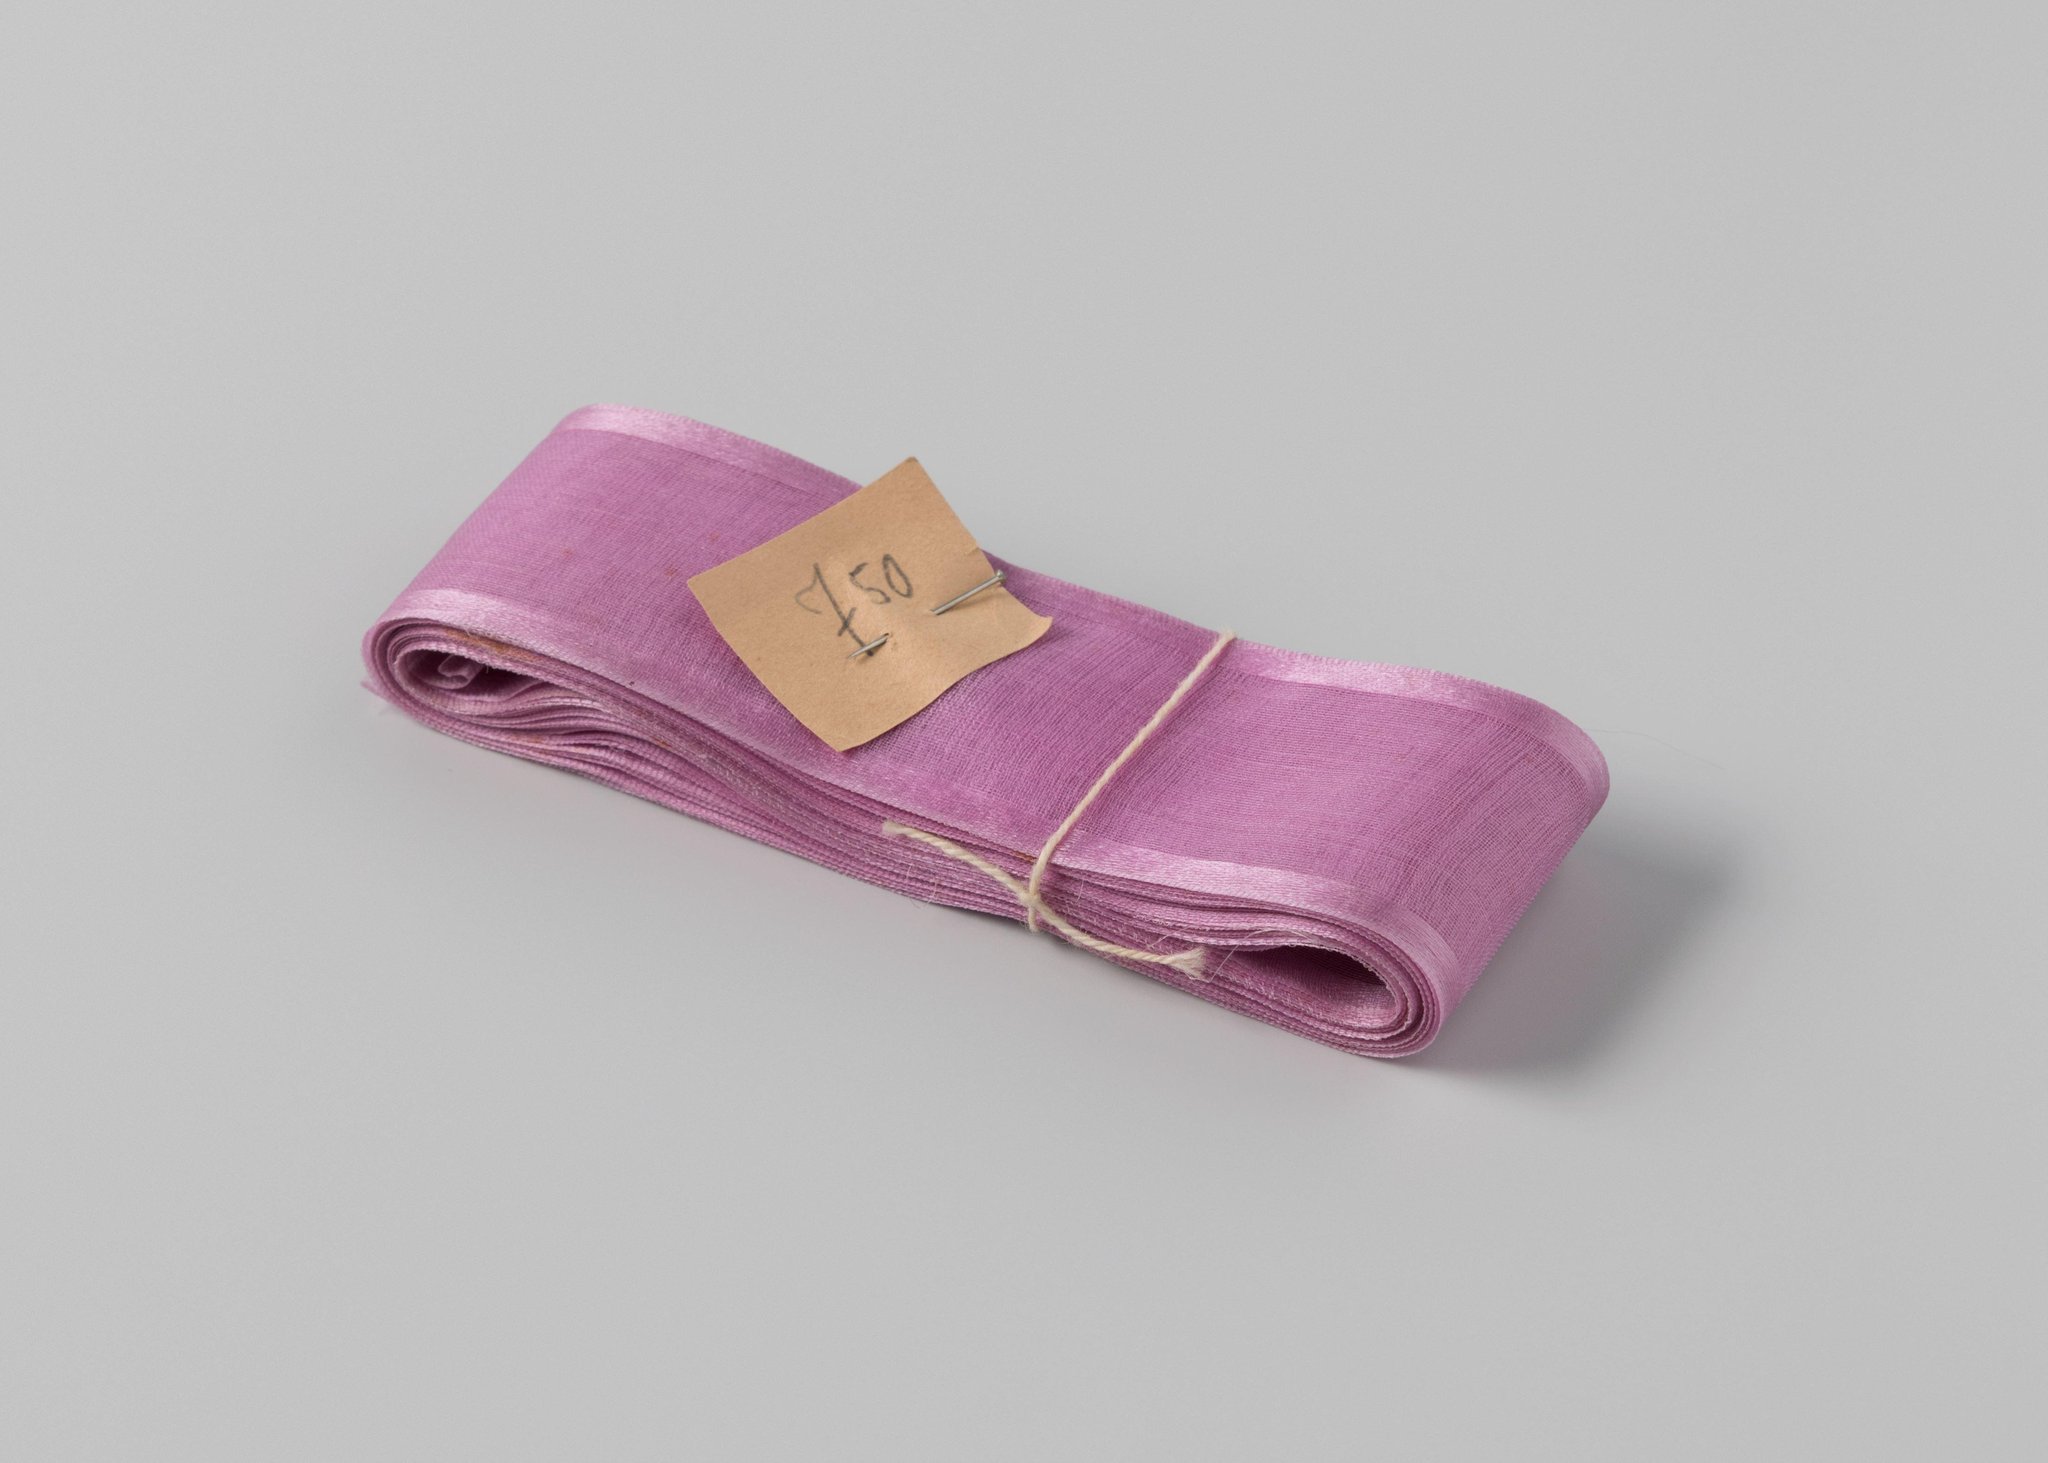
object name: braid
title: Lint van lila gaas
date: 1900-1915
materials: textile, silk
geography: nijmegen